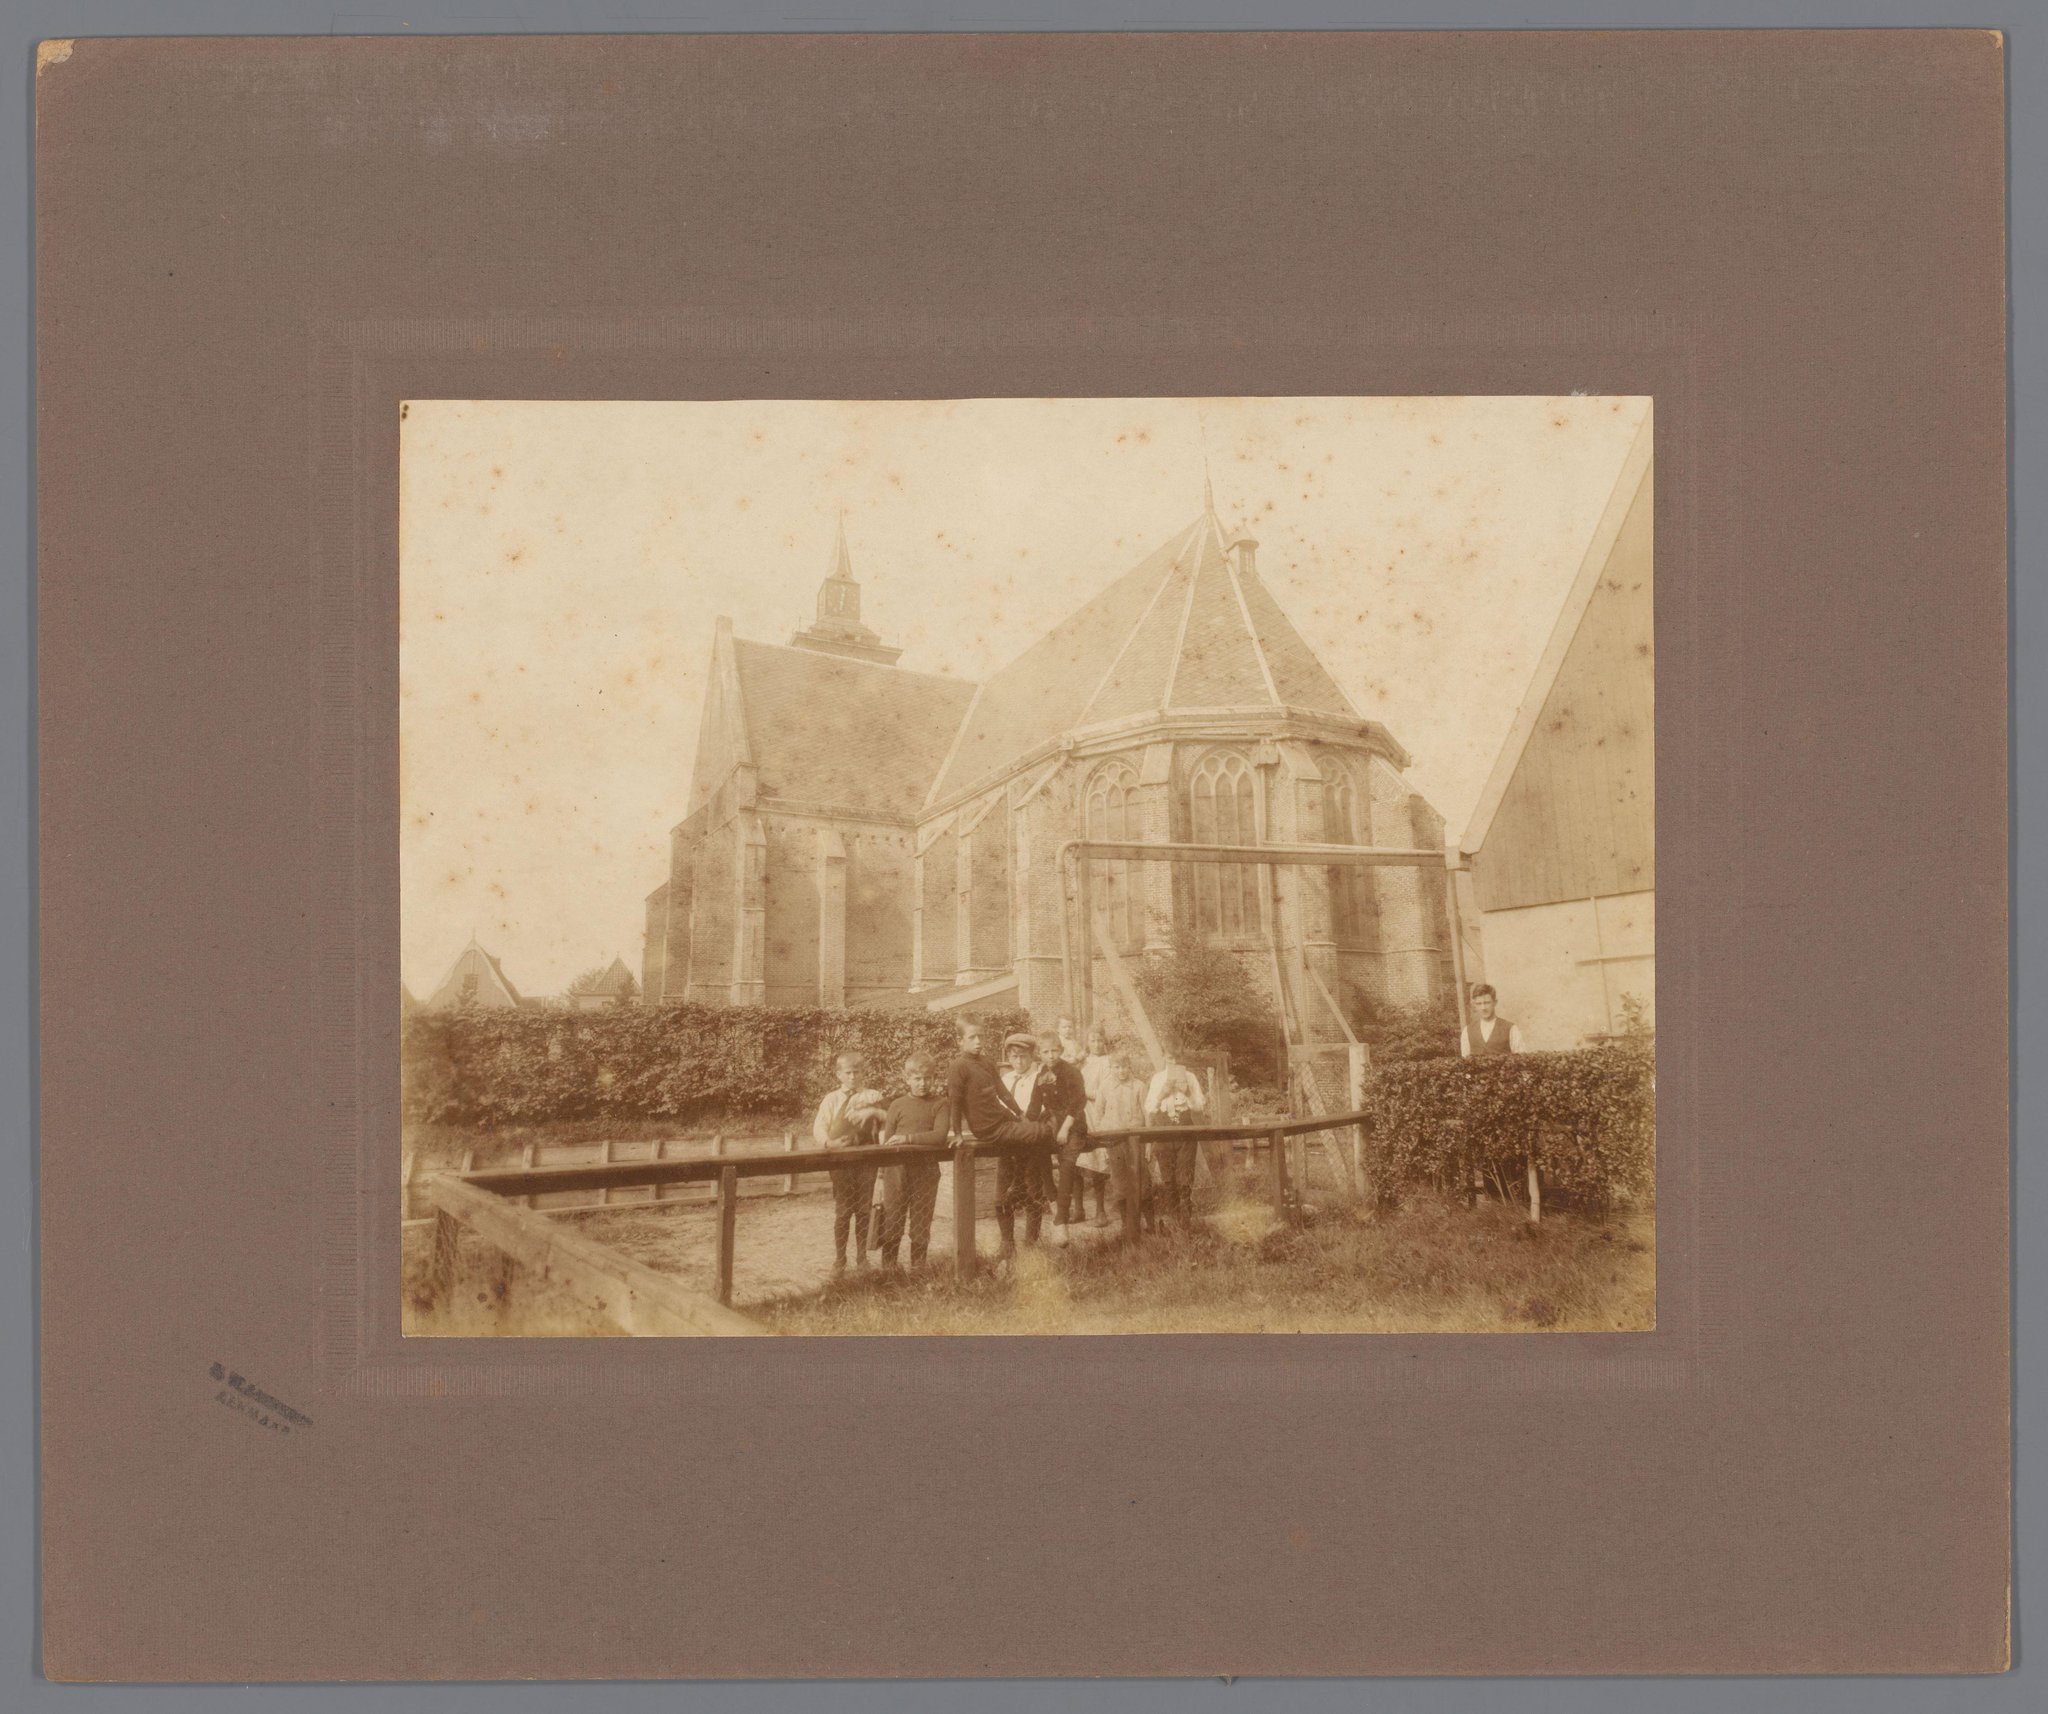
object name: photograph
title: Aanzicht Nederlands Hervormde Kerk in De Rijp, Noord-Holland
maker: leonard vlaanderen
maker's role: fotograaf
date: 1921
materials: cardboard, photographic support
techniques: gelatin silver print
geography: alkmaar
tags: de rijp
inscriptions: date, annotation: ‘De Rijp 1921’, stamp: ‘L. VLAANDEREN//ALKMAAR’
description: Aanzicht op apsis van de Nederlands Hervormde Kerk in De Rijp, Noord-Holland, met daarvoor een groepje kinderen poserend voor de camera.